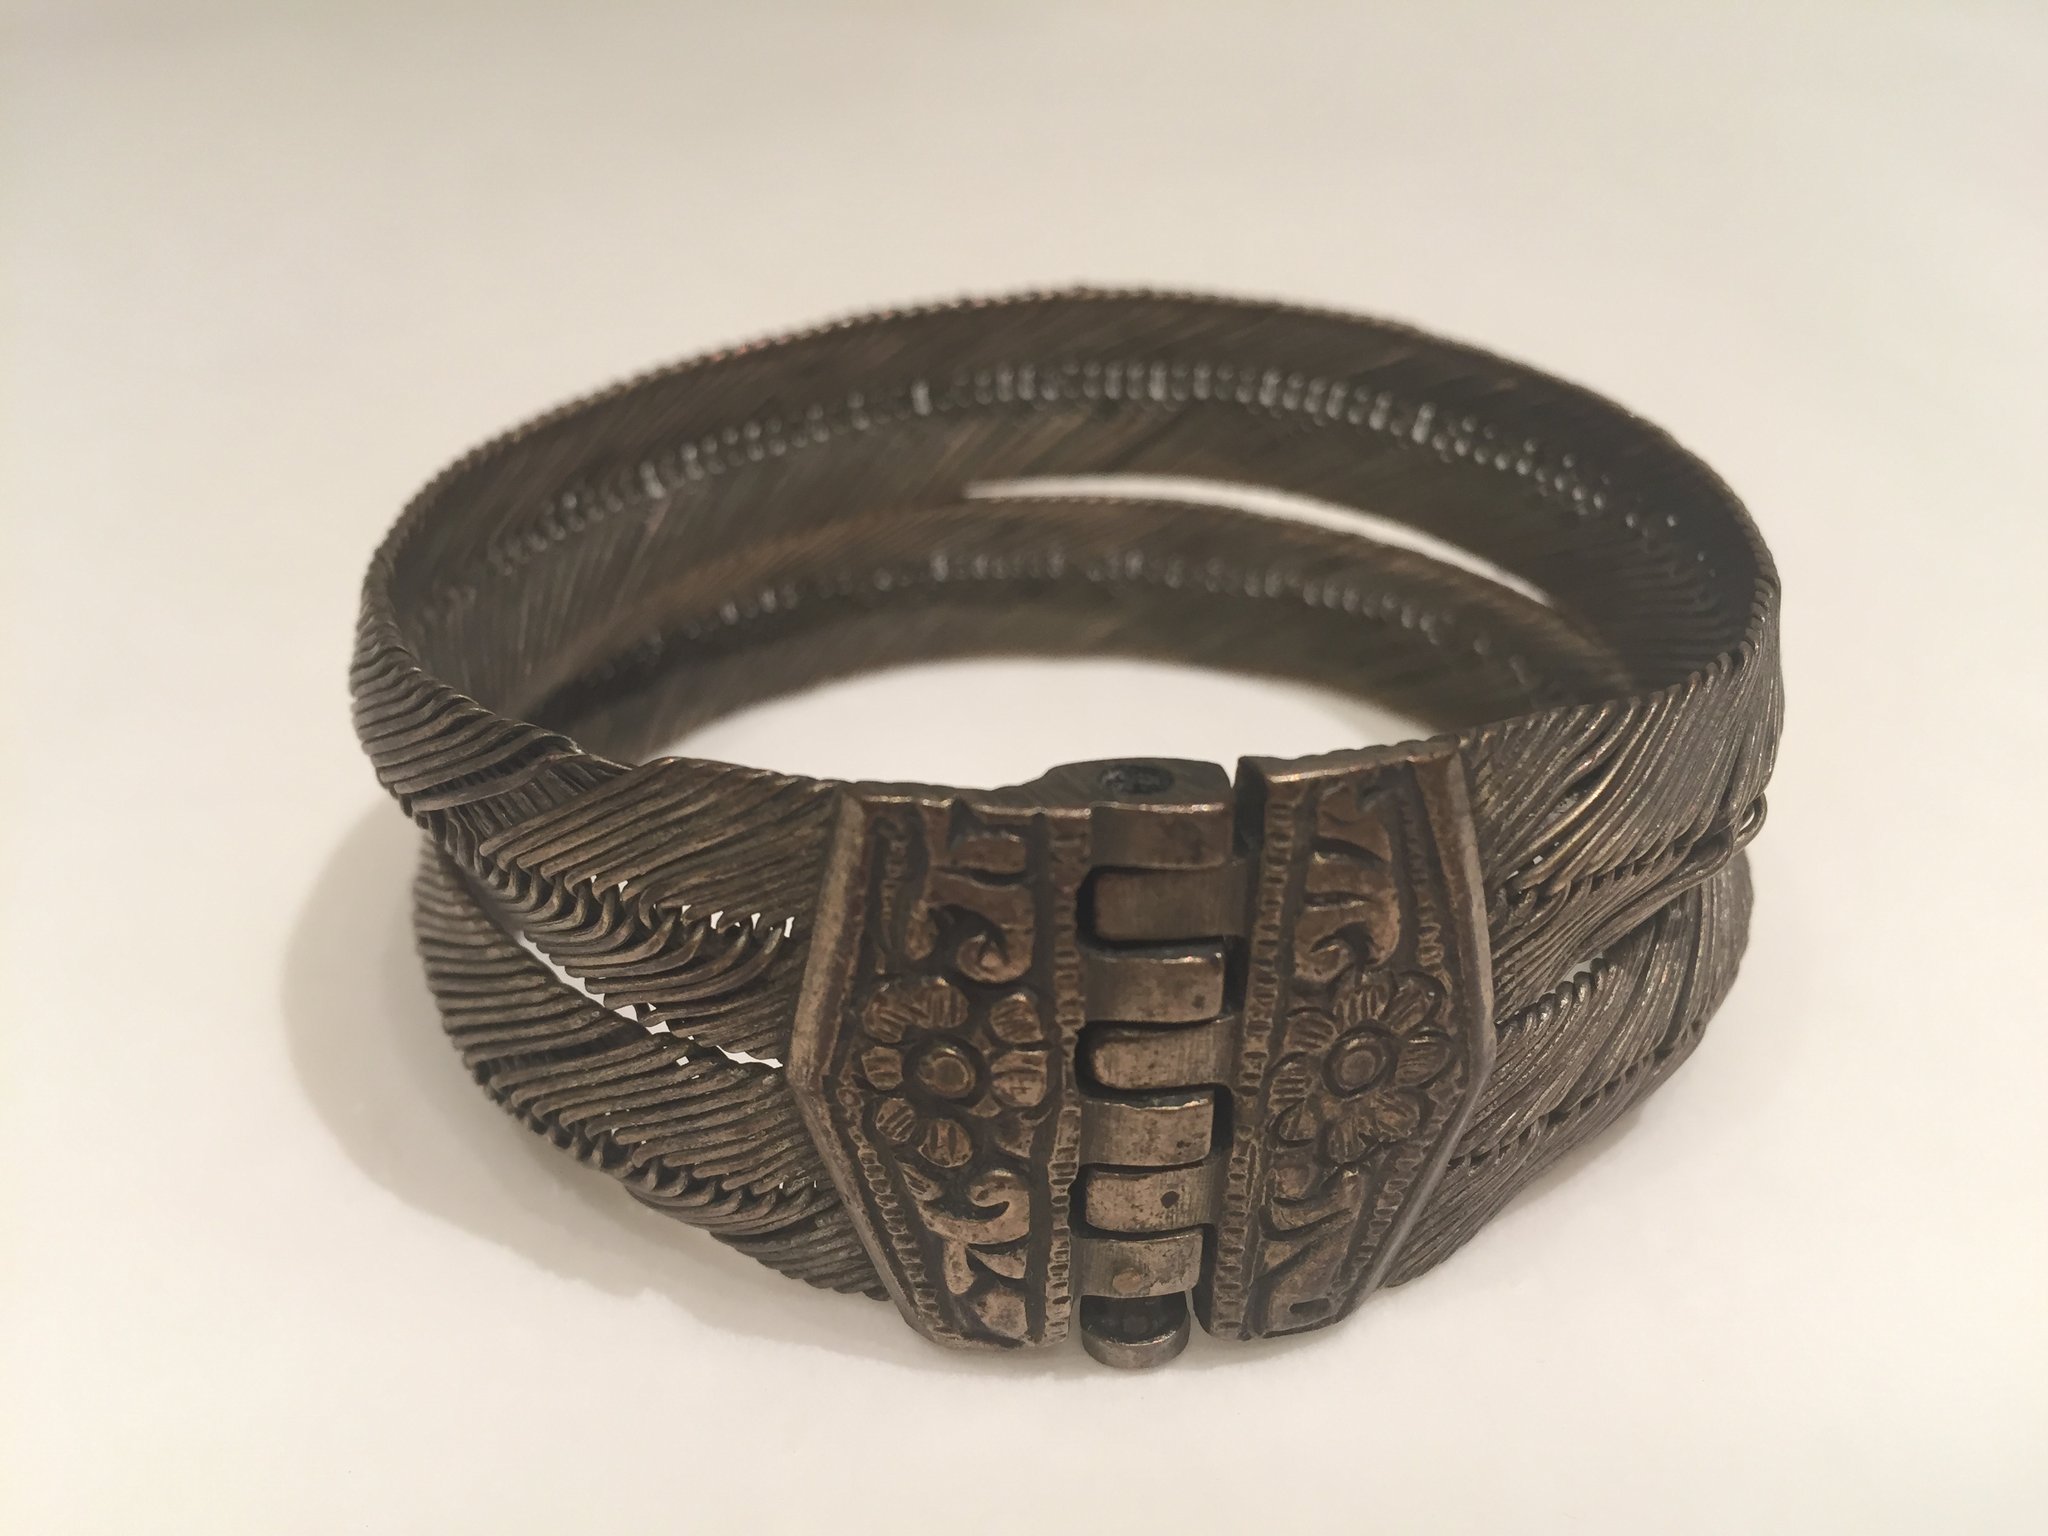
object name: bracelet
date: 1801-1900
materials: silver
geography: india